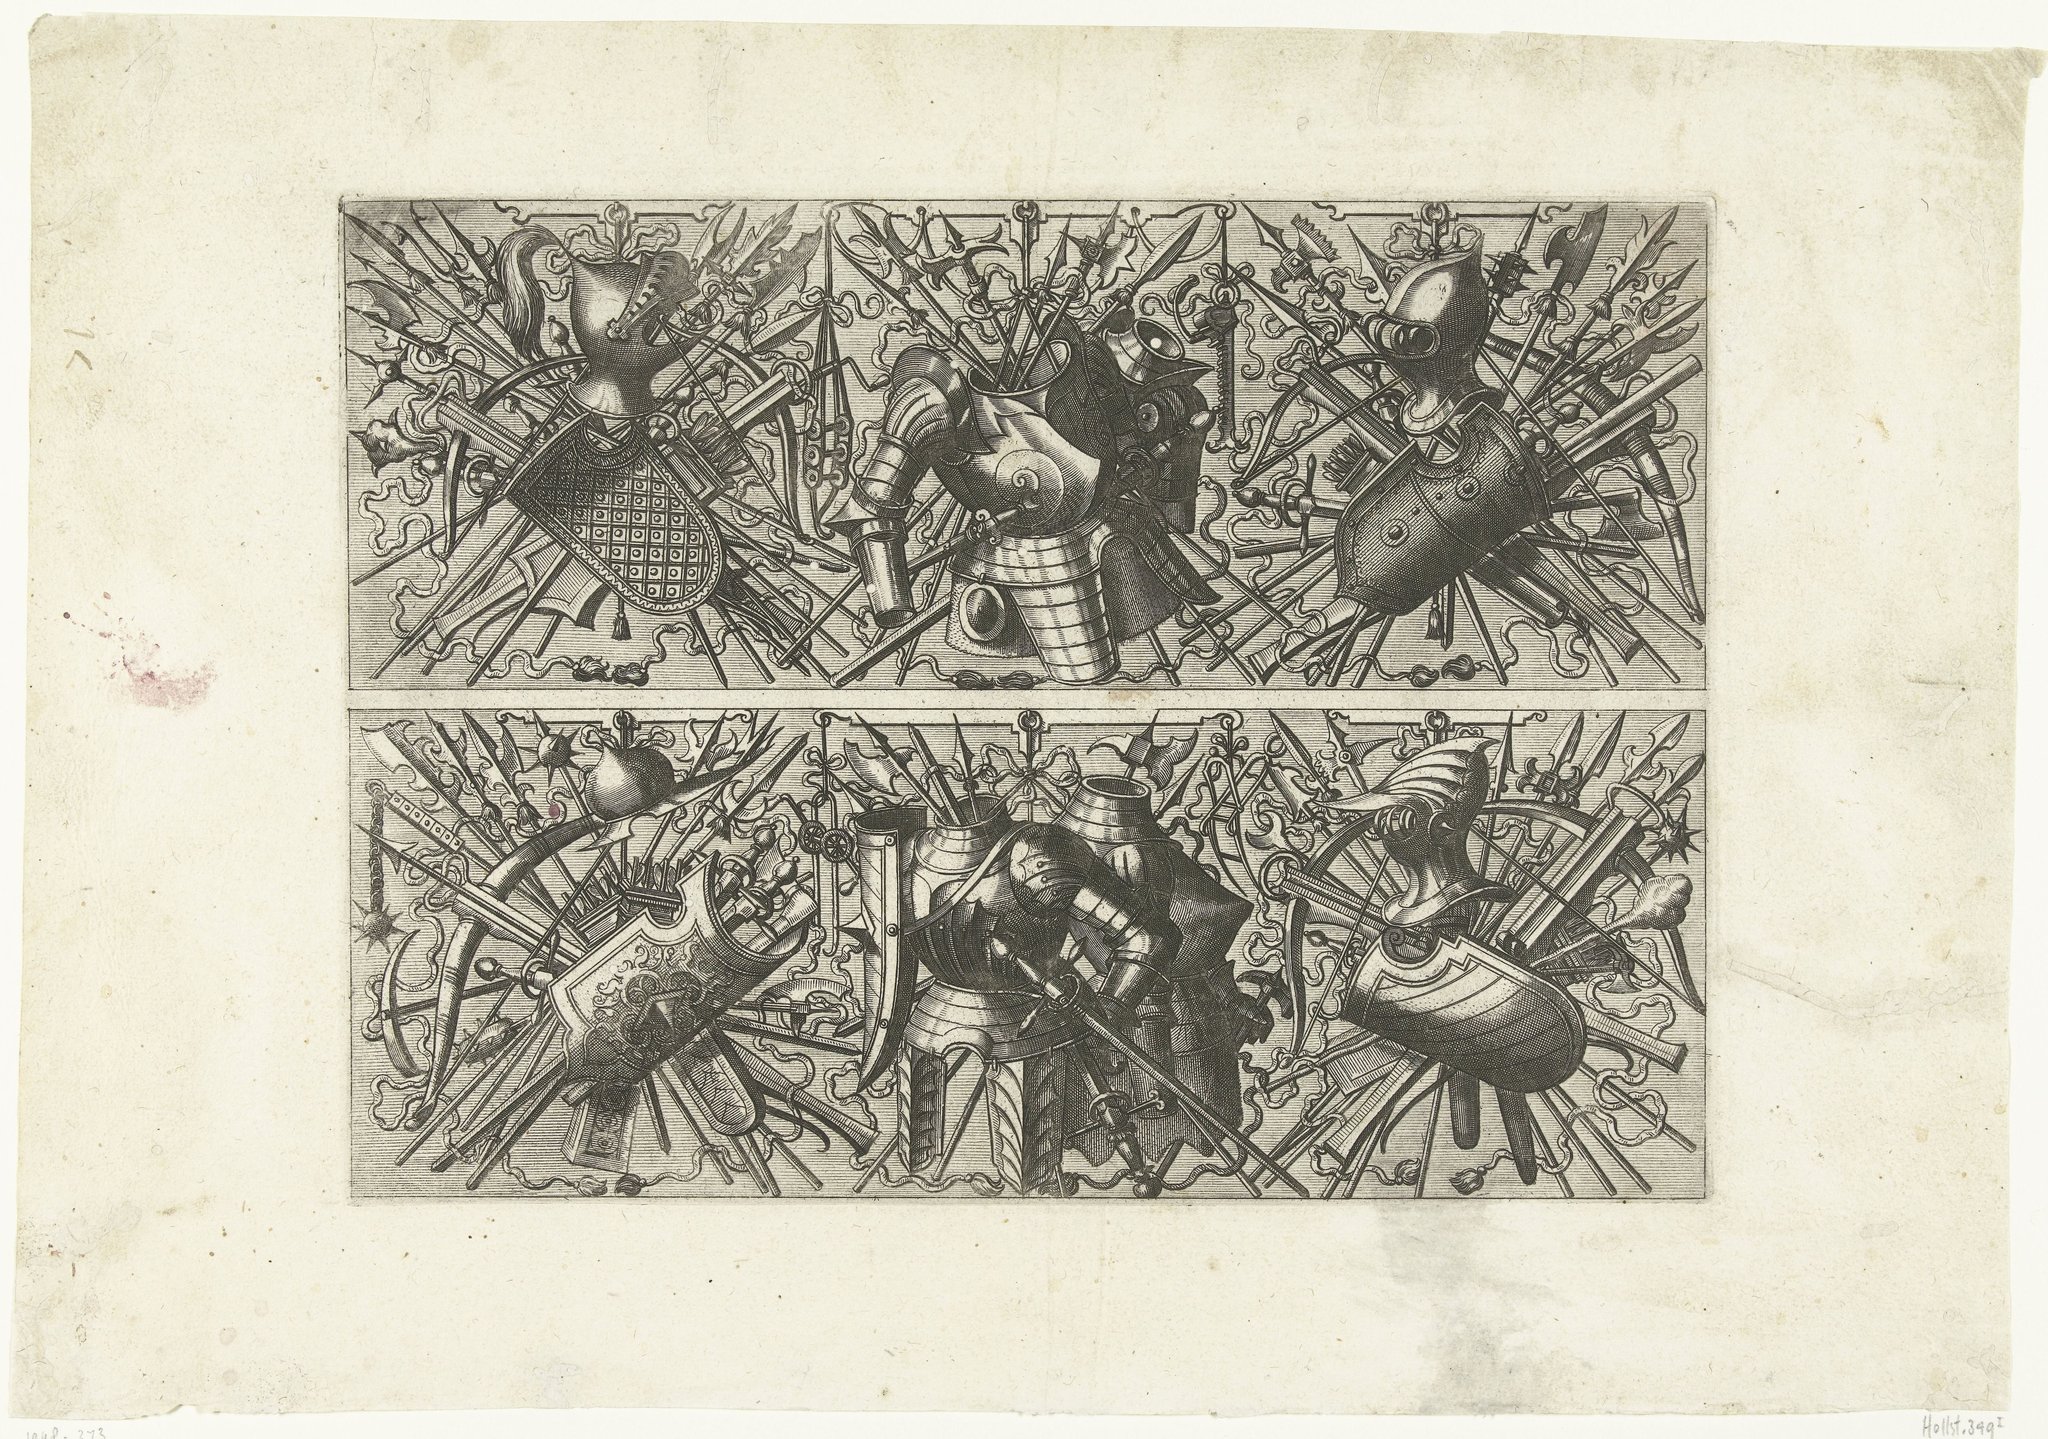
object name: print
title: Panoplia sev armamentarium…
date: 1572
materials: paper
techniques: etching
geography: netherlands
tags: trophy, i.e.: decorative arrangement of symbolic or typical objects ~ ornament, weapons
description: Twee horizontale compartimenten met trofeeën van wapens en delen van harnassen. (Hollst. 349-I)